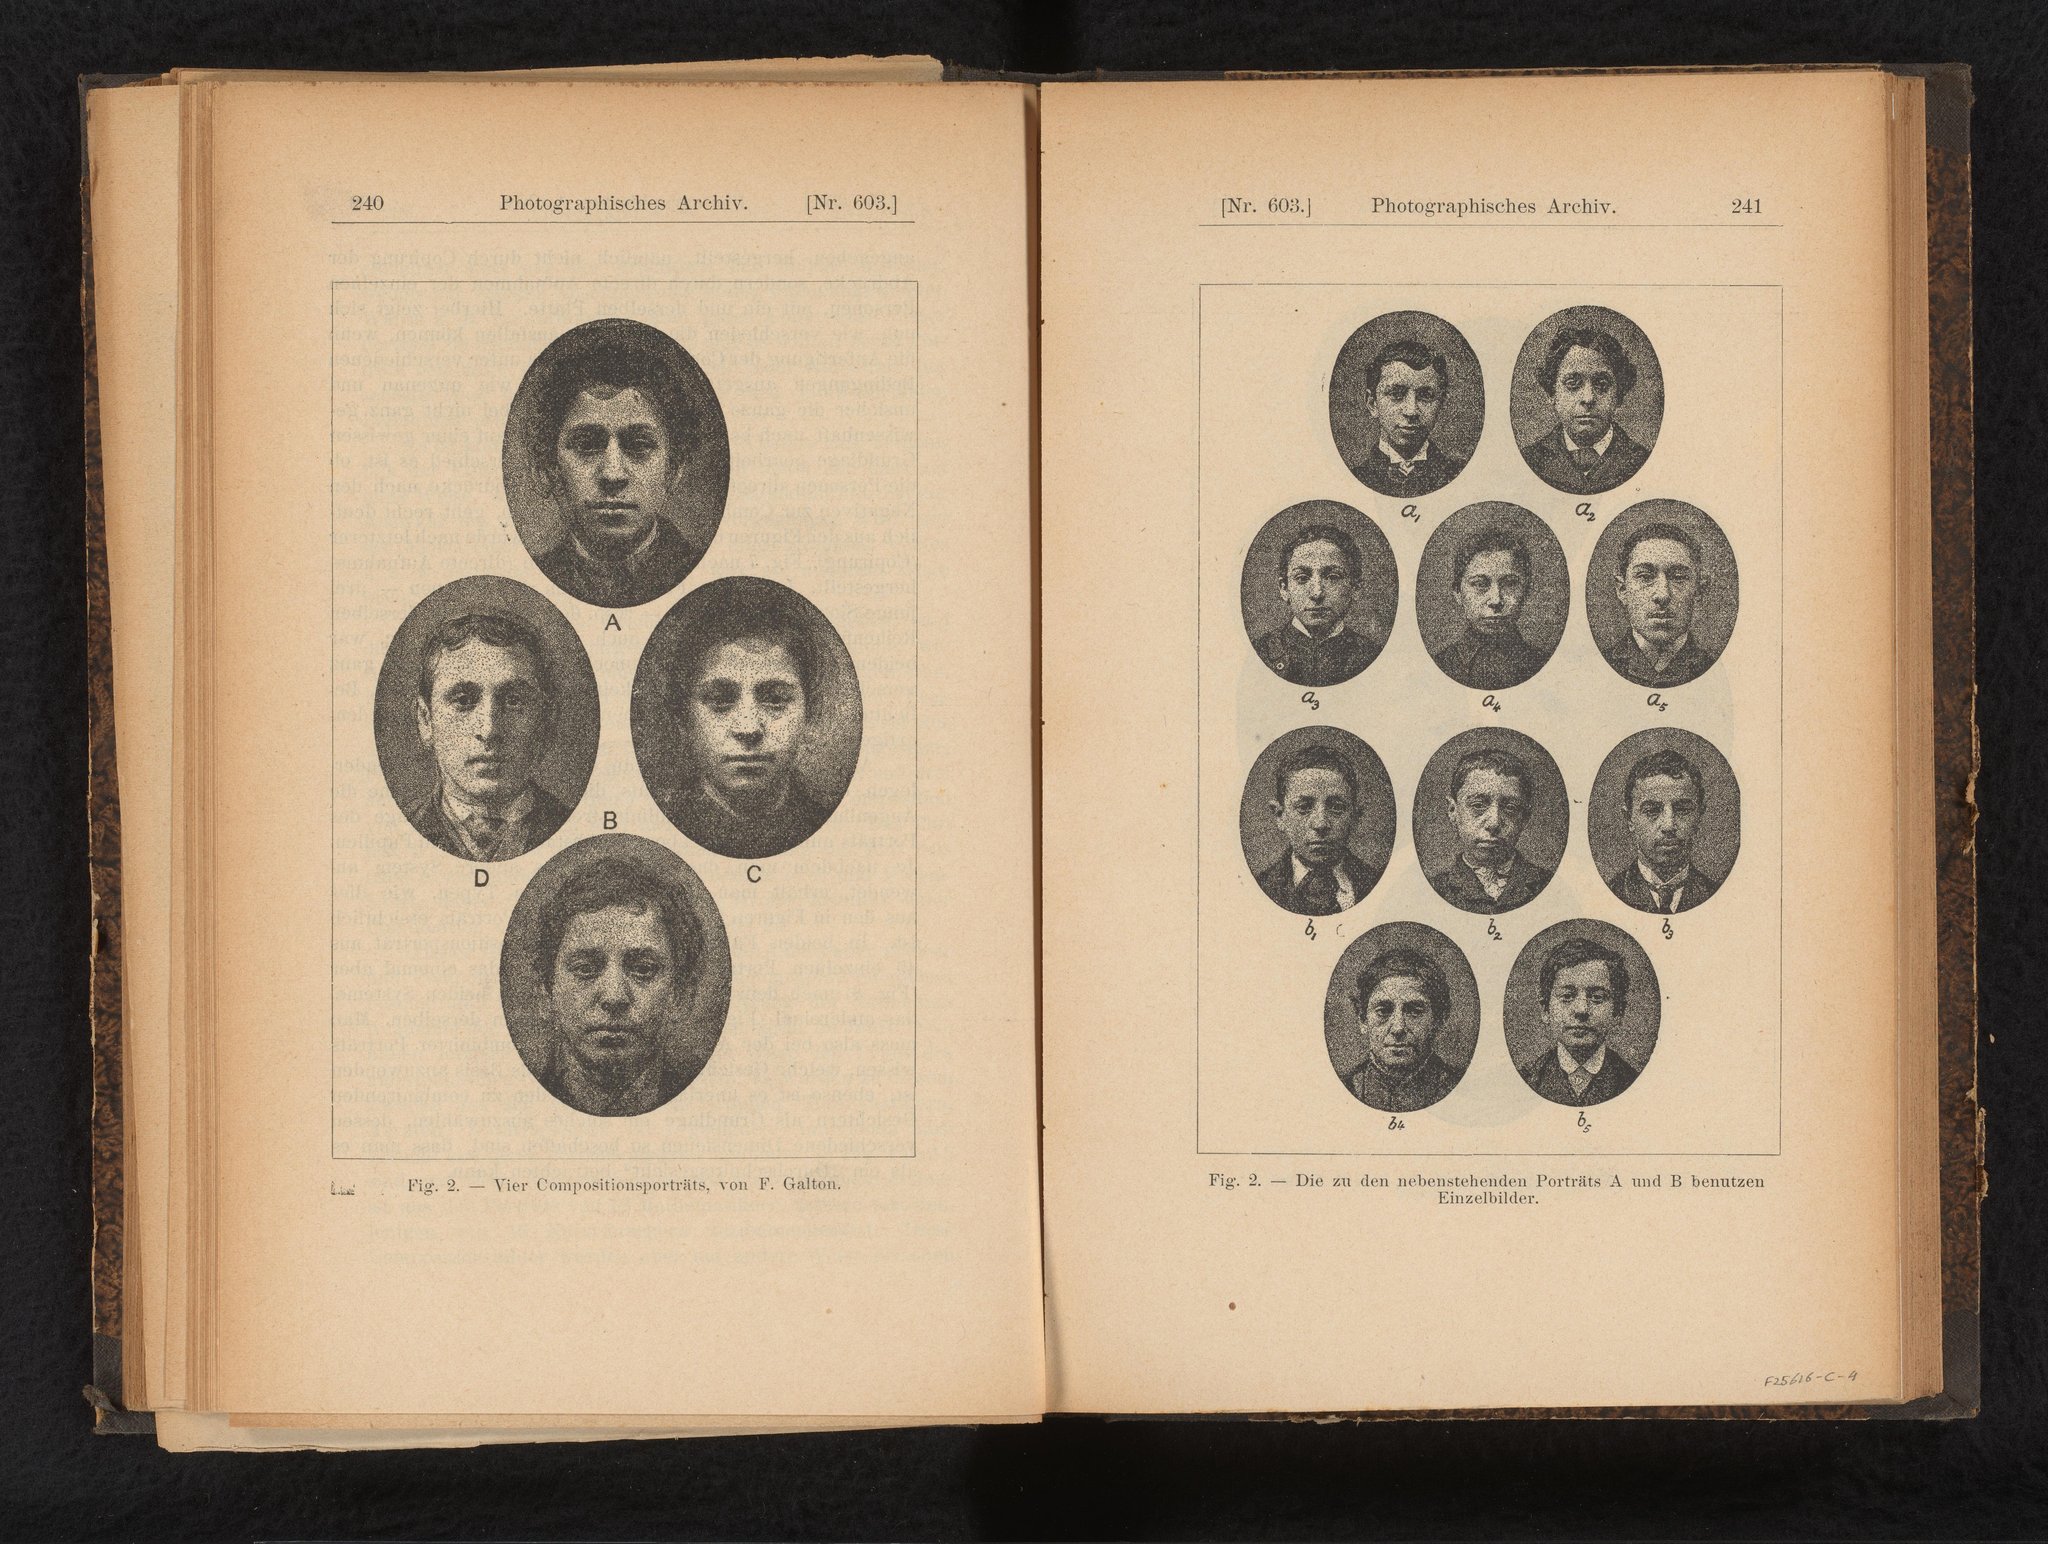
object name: page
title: Vire Compositionsporträts, von F. Galton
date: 1883-1888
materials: paper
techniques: photolithography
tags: historical persons not known by name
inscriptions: inscription: ‘Fig. 2.’